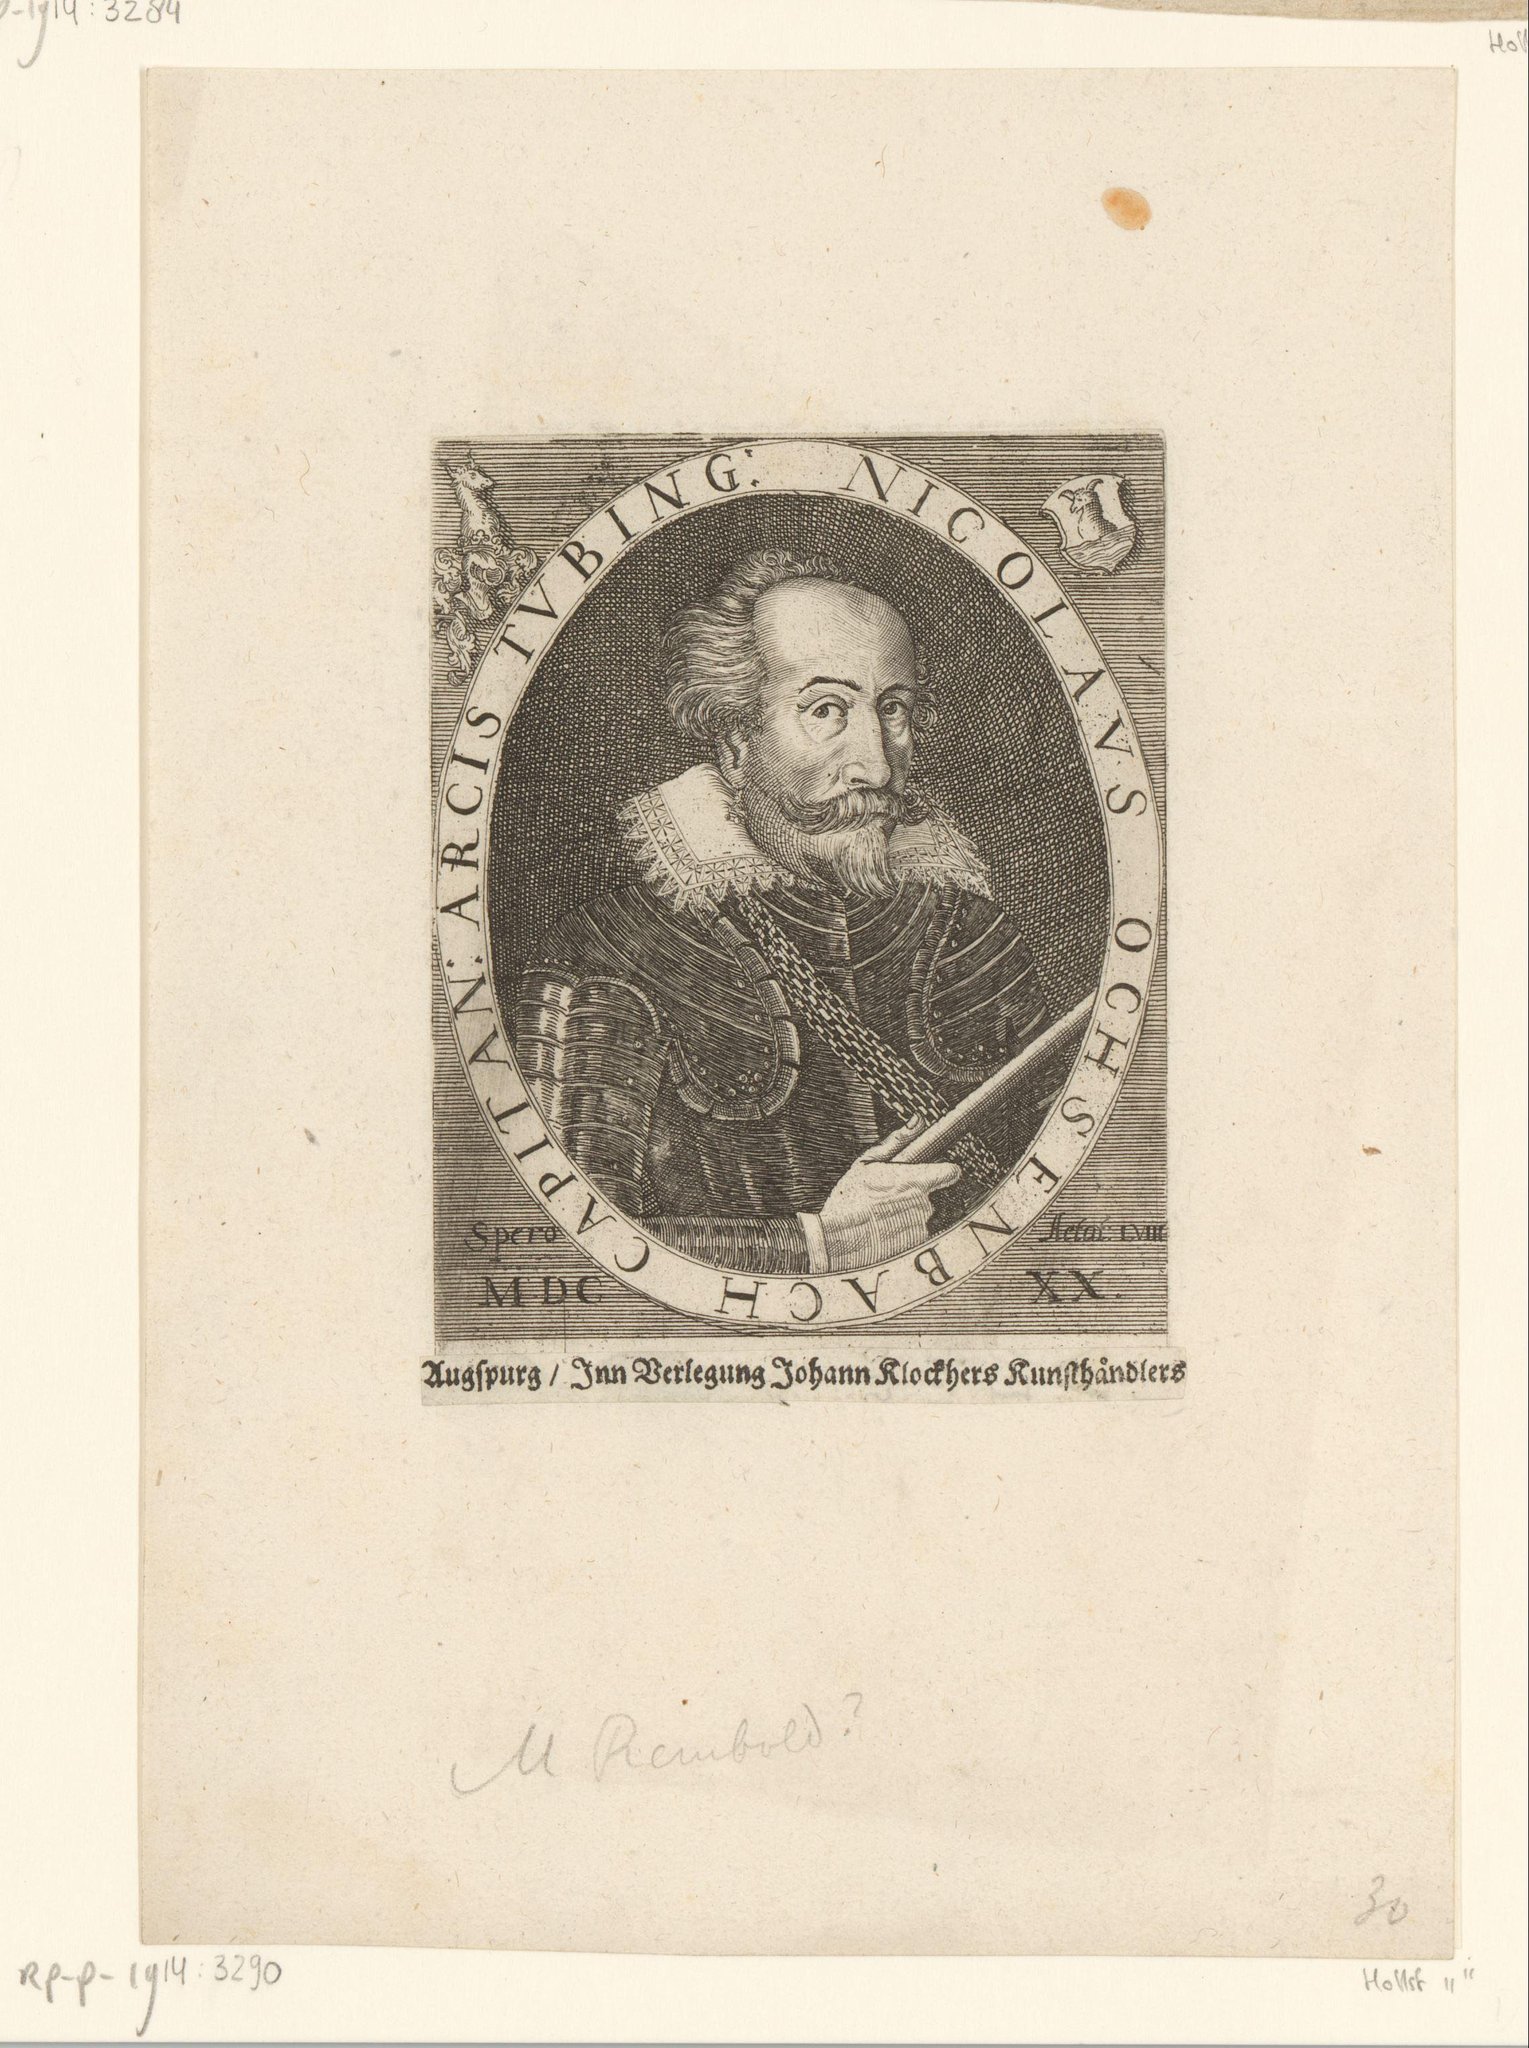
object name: print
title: Portret van Nikolaus Ochsenbach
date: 1646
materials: paper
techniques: engraving, letterpress printing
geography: augsburg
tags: armour, historical persons, baton of general, armorial bearing, heraldry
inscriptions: collector's mark: Lugt 2760, collector's mark: Lugt 2228